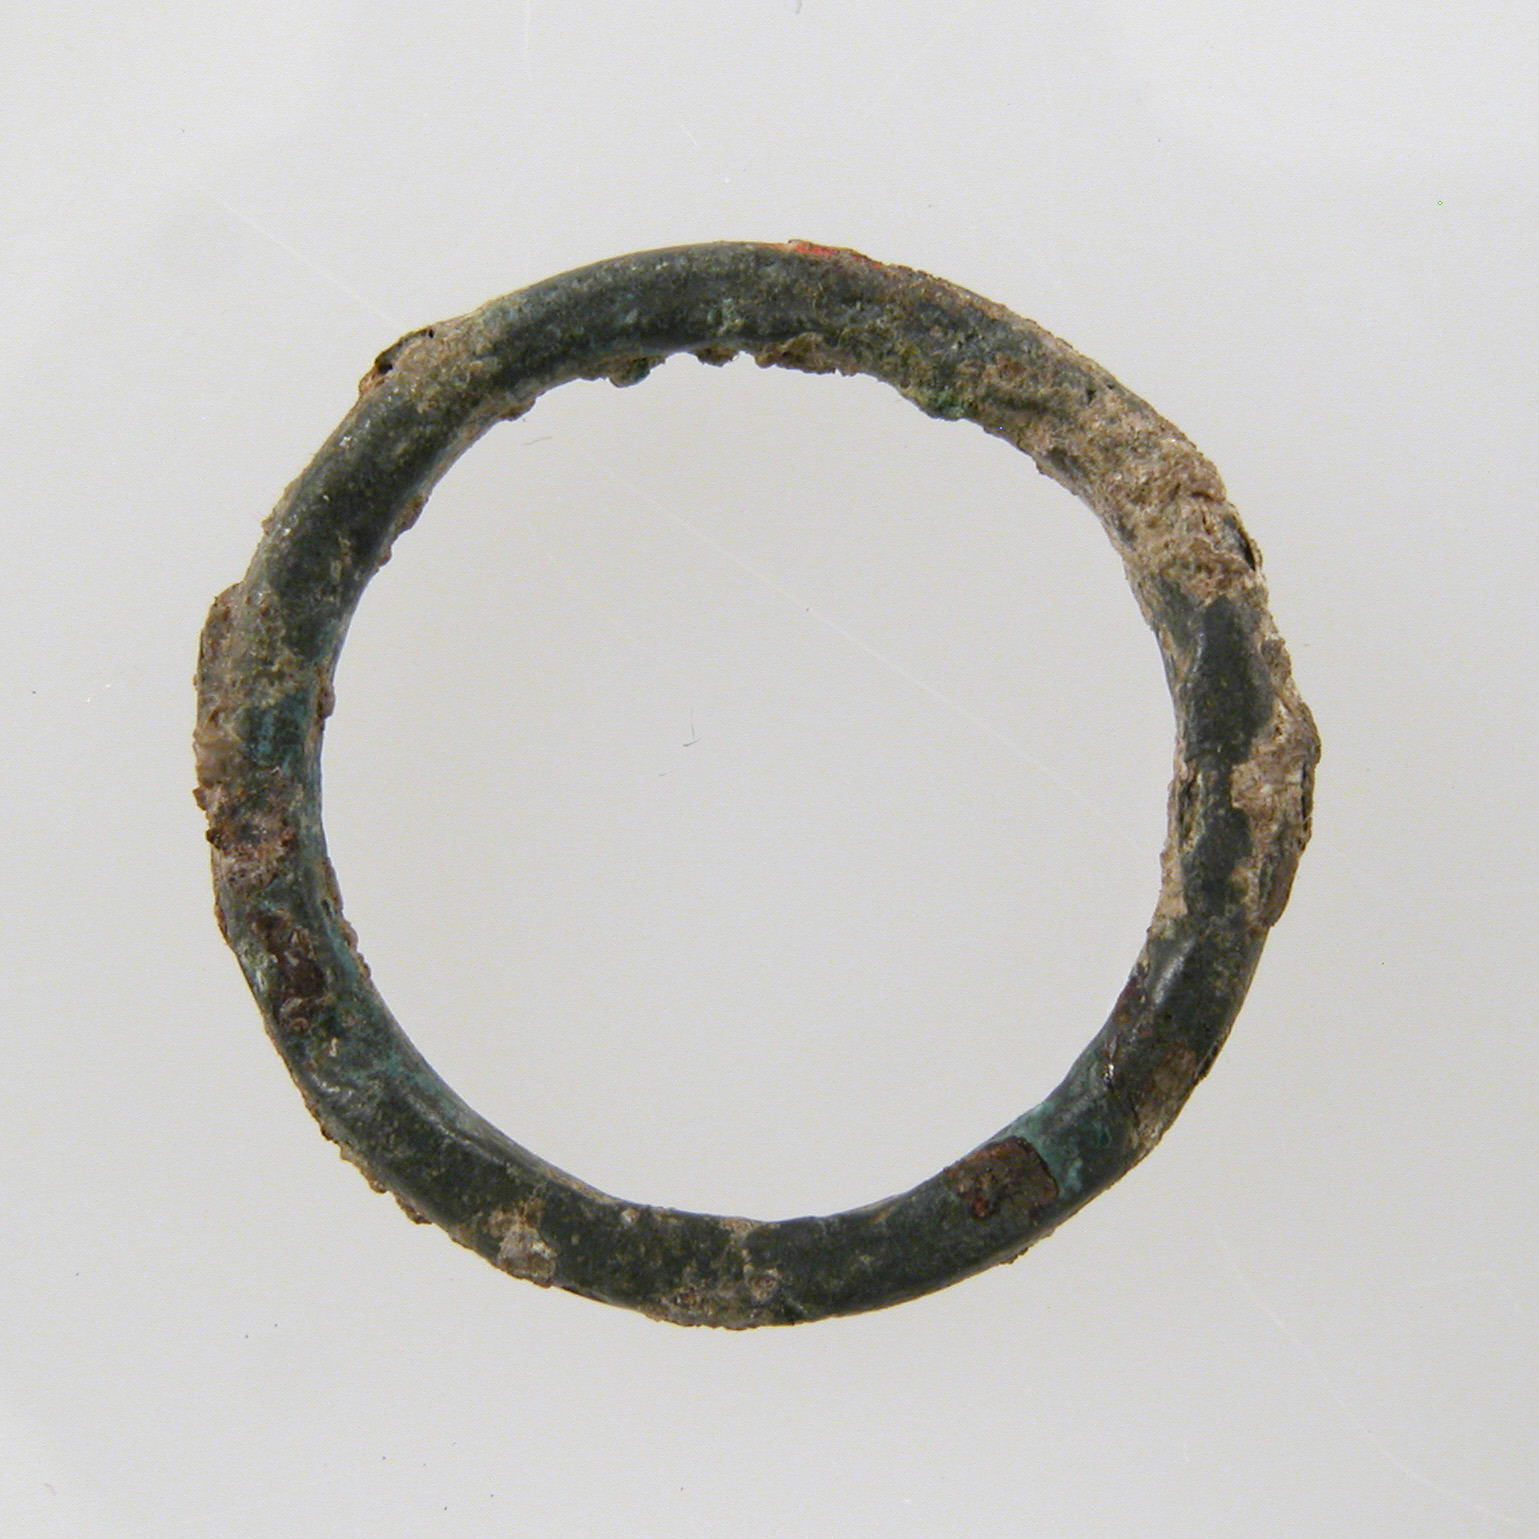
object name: ring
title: Plain Ring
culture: frankish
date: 601-700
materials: copper alloy